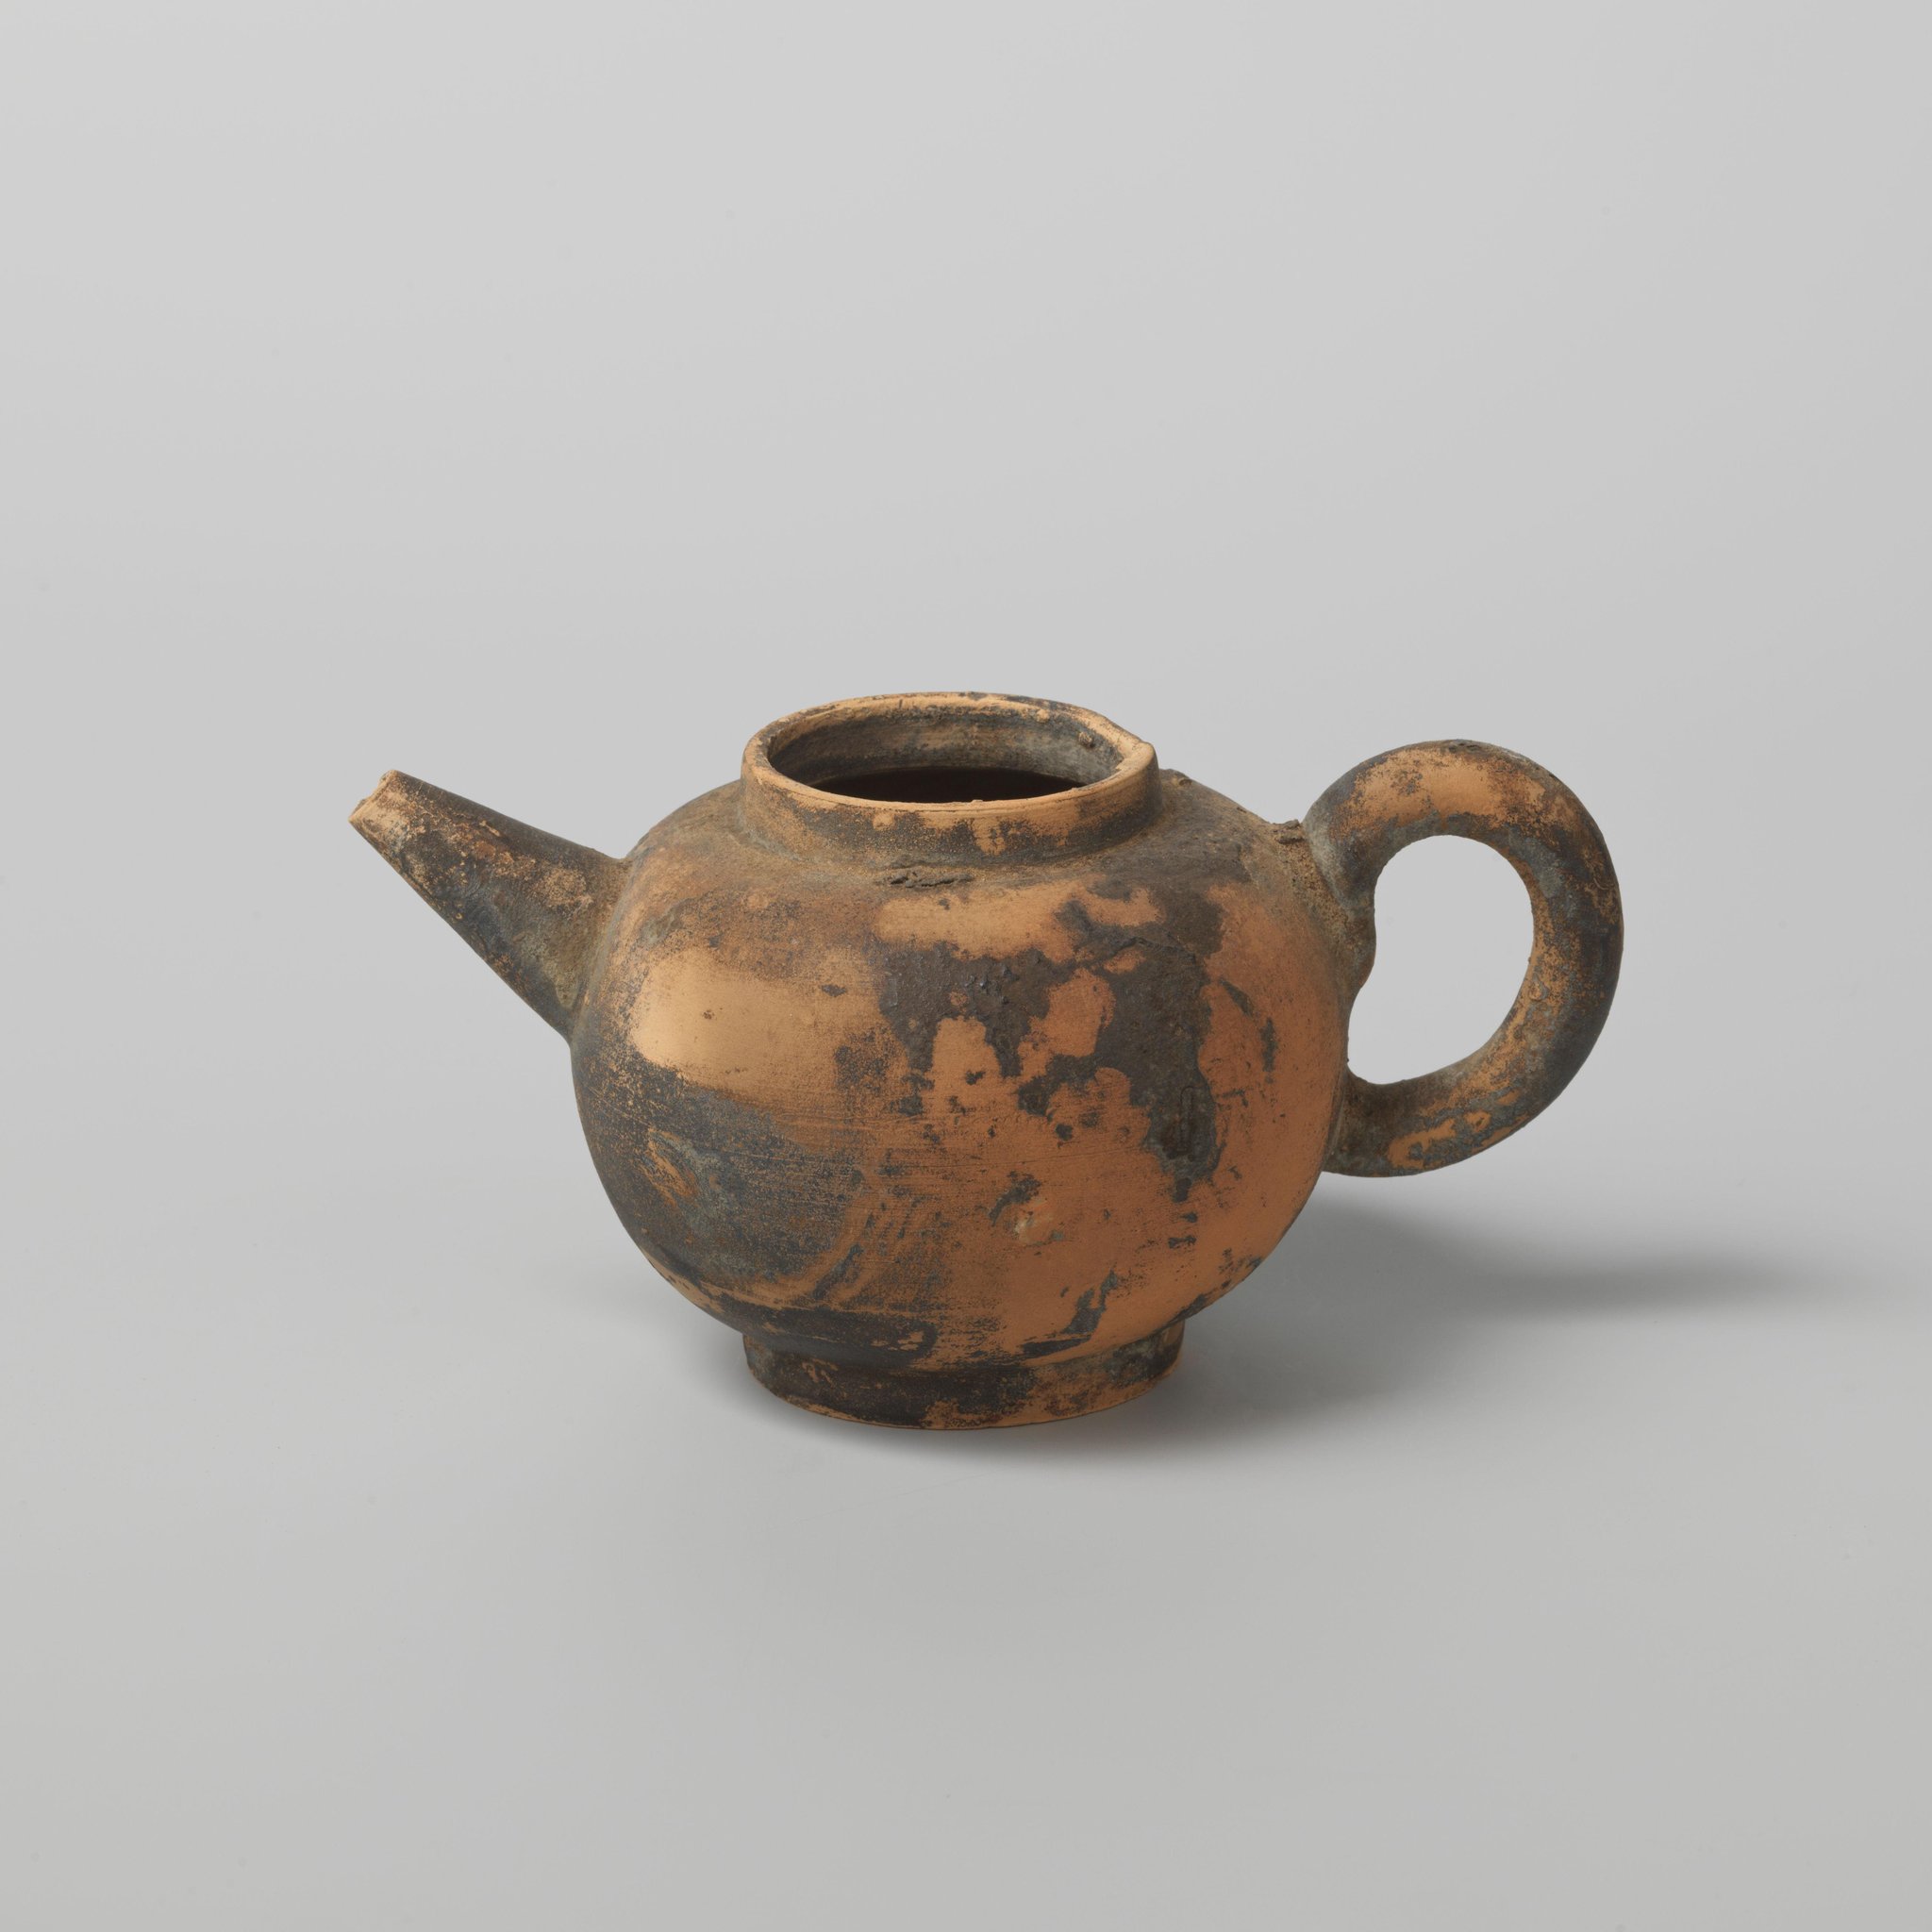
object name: teapot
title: Theepot van ongeglazuurd aardewerk met zwarte vlekken (De Caluwe bakafval)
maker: jacobus de caluwe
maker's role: plateelbakkerij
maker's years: -1730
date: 1700-1725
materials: earthenware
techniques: firing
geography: delft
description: Toegeschreven aan Jacobus de Caluwe, omdat dit voorwerp samen met gemerkte stukken (‘Jacobus De Caluwe’ en rennend hert) gevonden is op de plaats waar zich De Caluwes tweede werkplaats bevond. Er is een duidelijke stilistische overeenkomst tussen de gemerkte en niet gemerkte voorwerpen uit deze archeologische vondst.